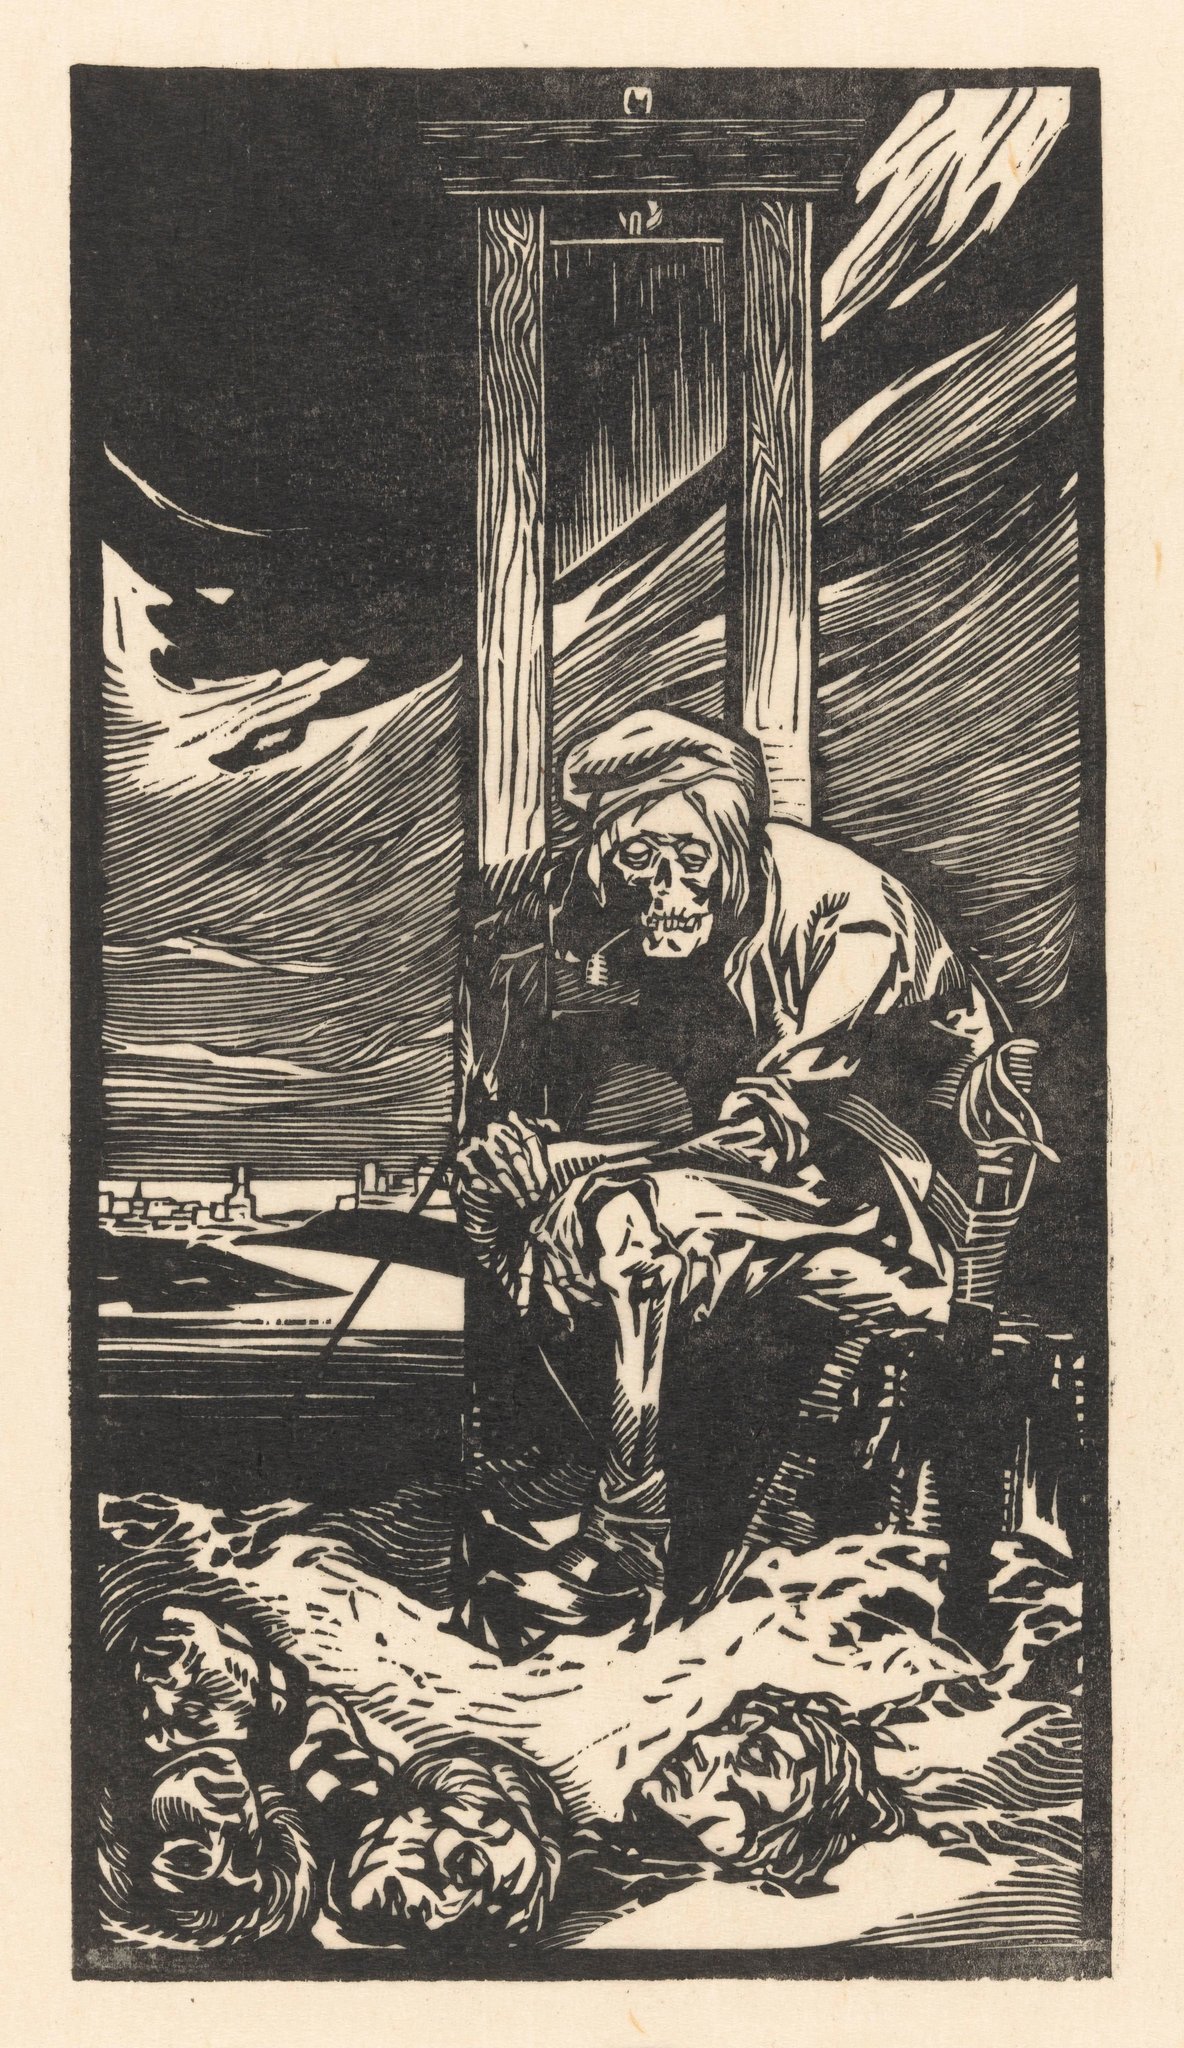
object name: print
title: De Dood bij de guillotine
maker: johannes josephus aarts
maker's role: draughtsman, print maker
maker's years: 1871-1934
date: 1881-1934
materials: paper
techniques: woodcut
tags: violent death ~ beheading by guillotine, death as man, head of a beheaded person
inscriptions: collector's mark: Lugt 2760, collector's mark: Lugt 2166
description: Aarts heeft deze voorstelling in 1927 ook als lithografie uitgevoerd. Wielick (1986) geeft als titel voor deze prent 'Danse Macabre - Égalité'.